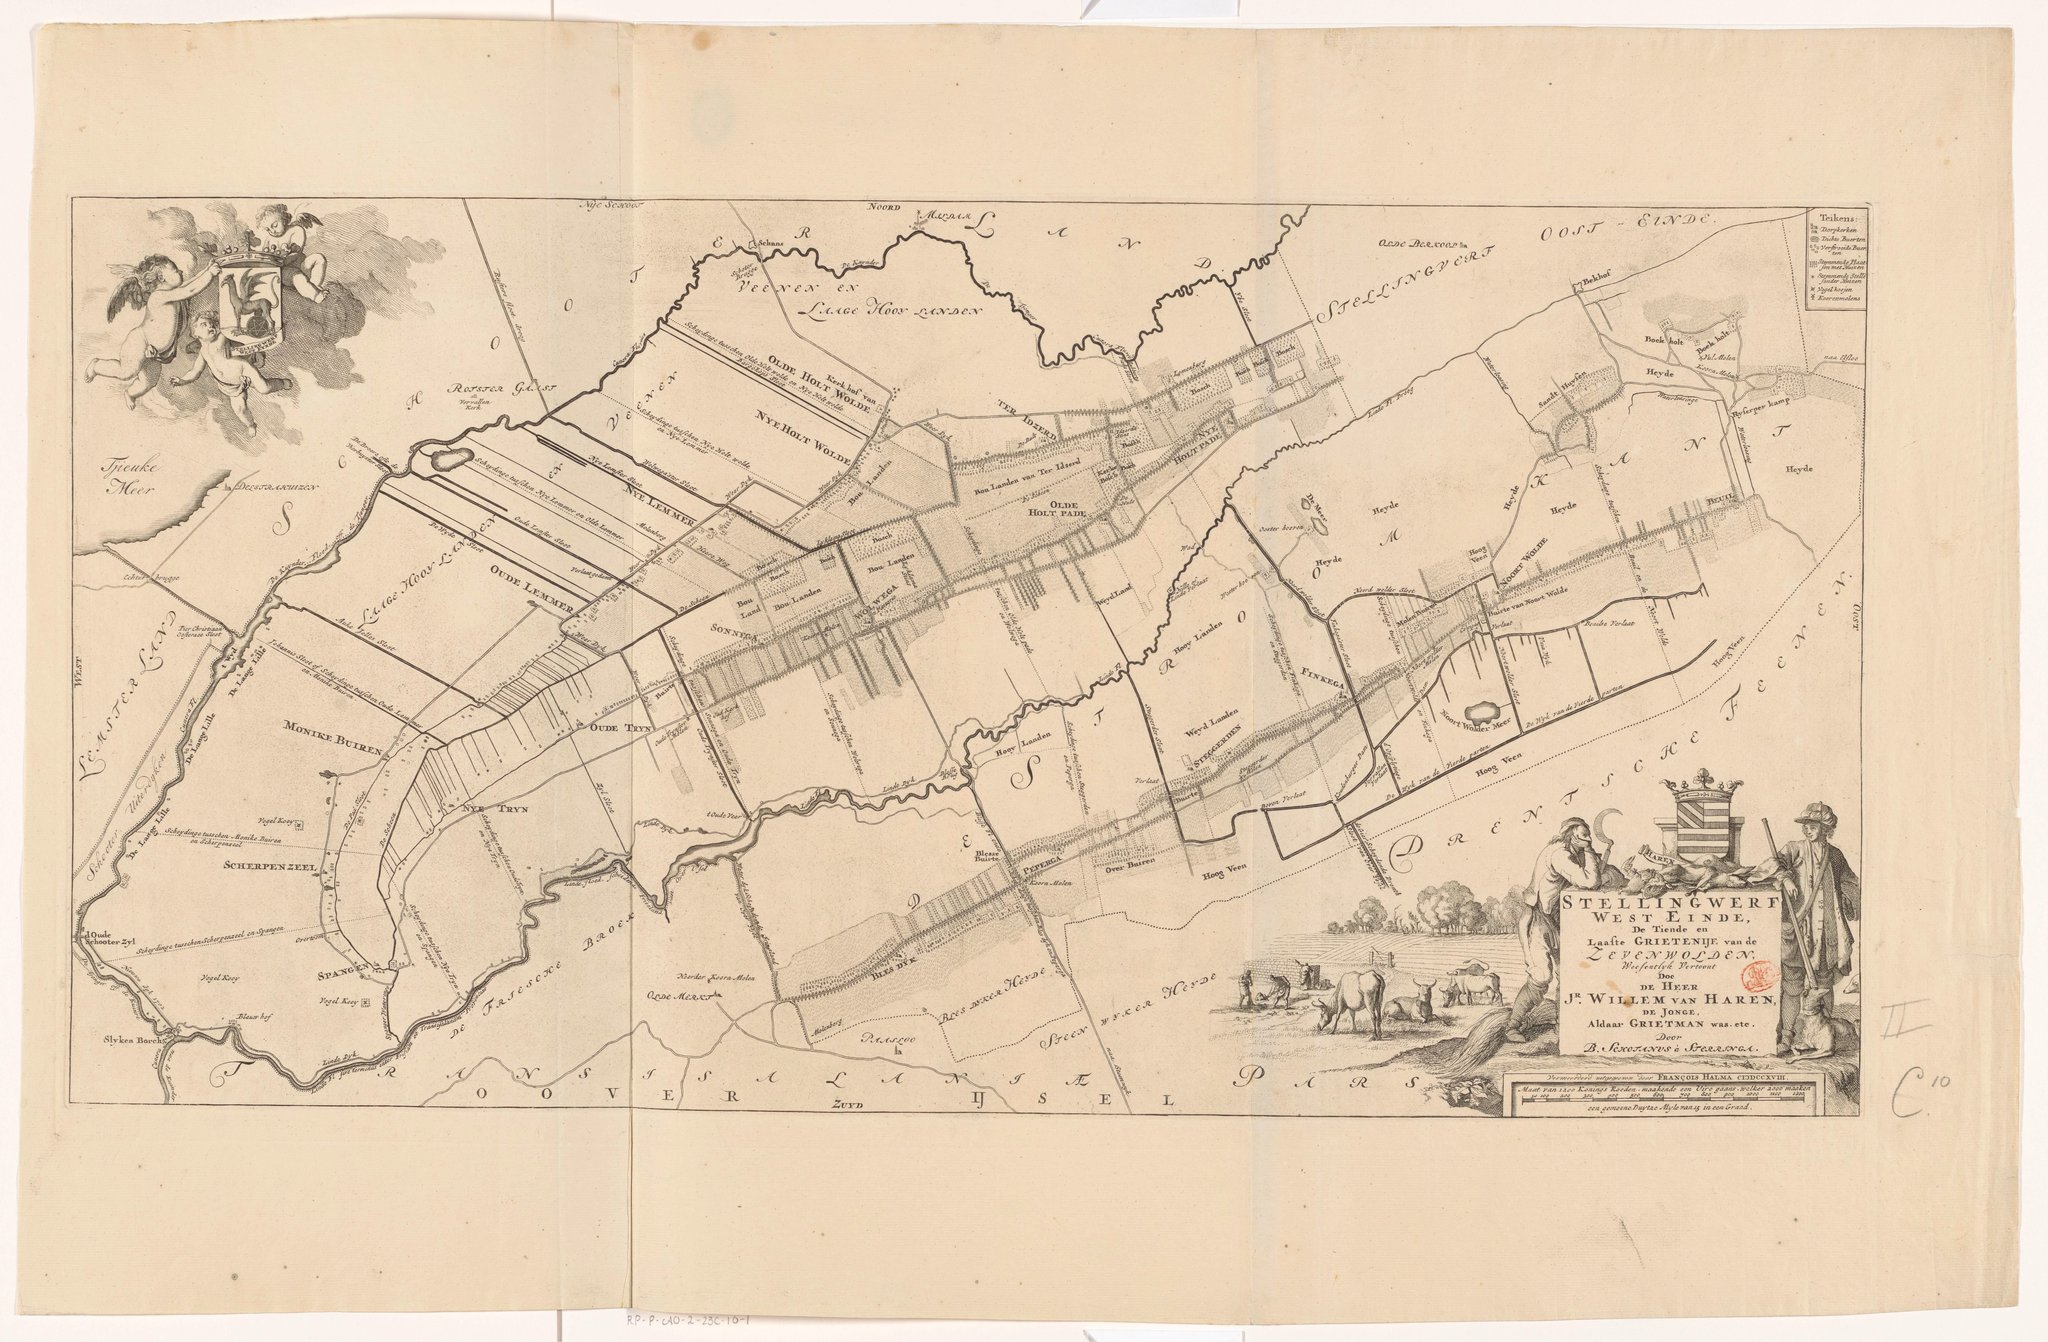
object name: print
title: Kaart van de grietenij Weststellingwerf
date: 1698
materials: paper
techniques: engraving, etching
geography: friesland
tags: coat of arms (as symbol of the state, etc.), peat-cutting, maps of separate countries or regions, hunter, farmers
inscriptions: collector's mark: Lugt 195, collector's mark: Lugt 2228, label: ‘264’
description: Linksboven het wapen van Weststellingwerf. Rechtsboven legenda, rechtsonder cartouche met titel en bestuurlijke informatie over de grietenij. Daaromheen een landbouwer, een jager en het wapen van grietman jonker Willem van Haren de jonge. Links daarvan turfstekers aan het werk. Onder de cartouche een schaalstok: Maat van 1200 konings roeden, maakende een uire gaans, welker 2000 maaken een gemeene Duytze myle van 15 in een graad.